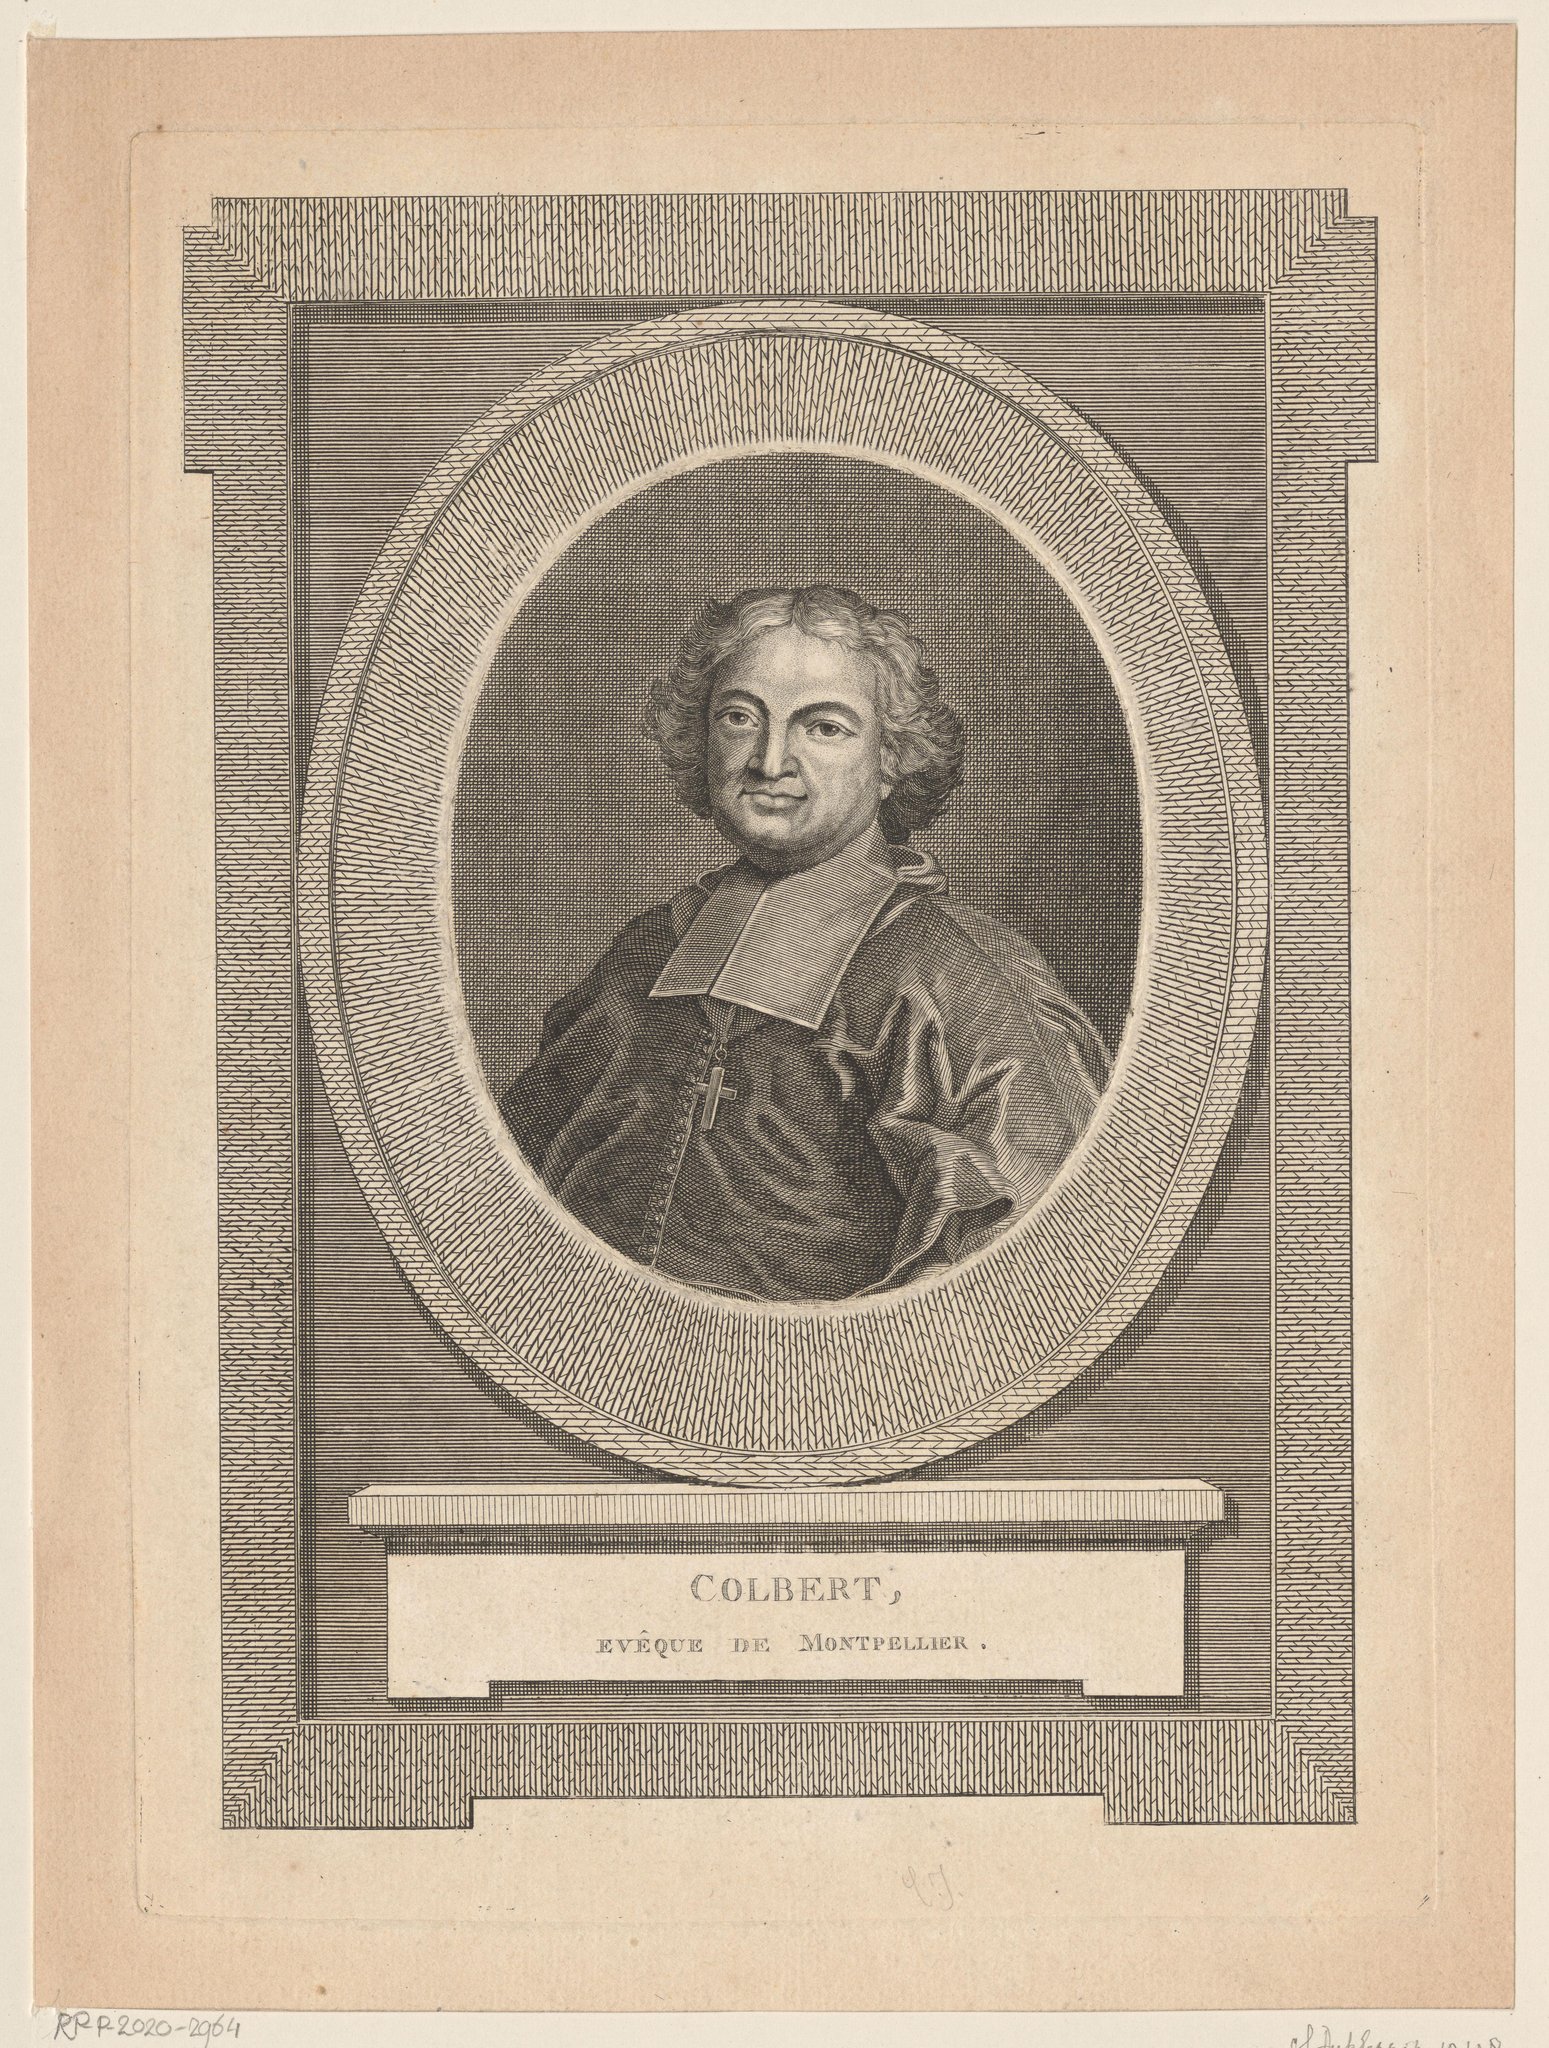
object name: print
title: Portret van Charles-Joachim Colbert de Croissy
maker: Anonymous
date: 1697-1749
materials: paper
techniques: engraving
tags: historical persons